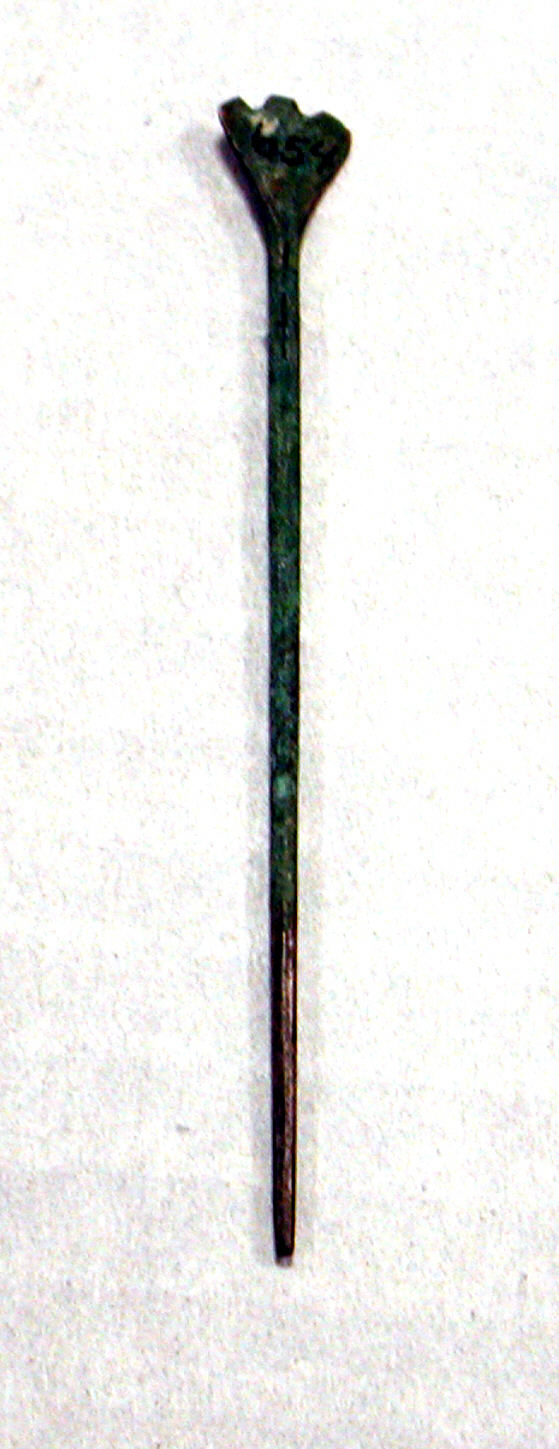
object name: pin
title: Hammered Copper Pin (tupu)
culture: peruvian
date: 701-1566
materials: copper, silver gilt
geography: peru